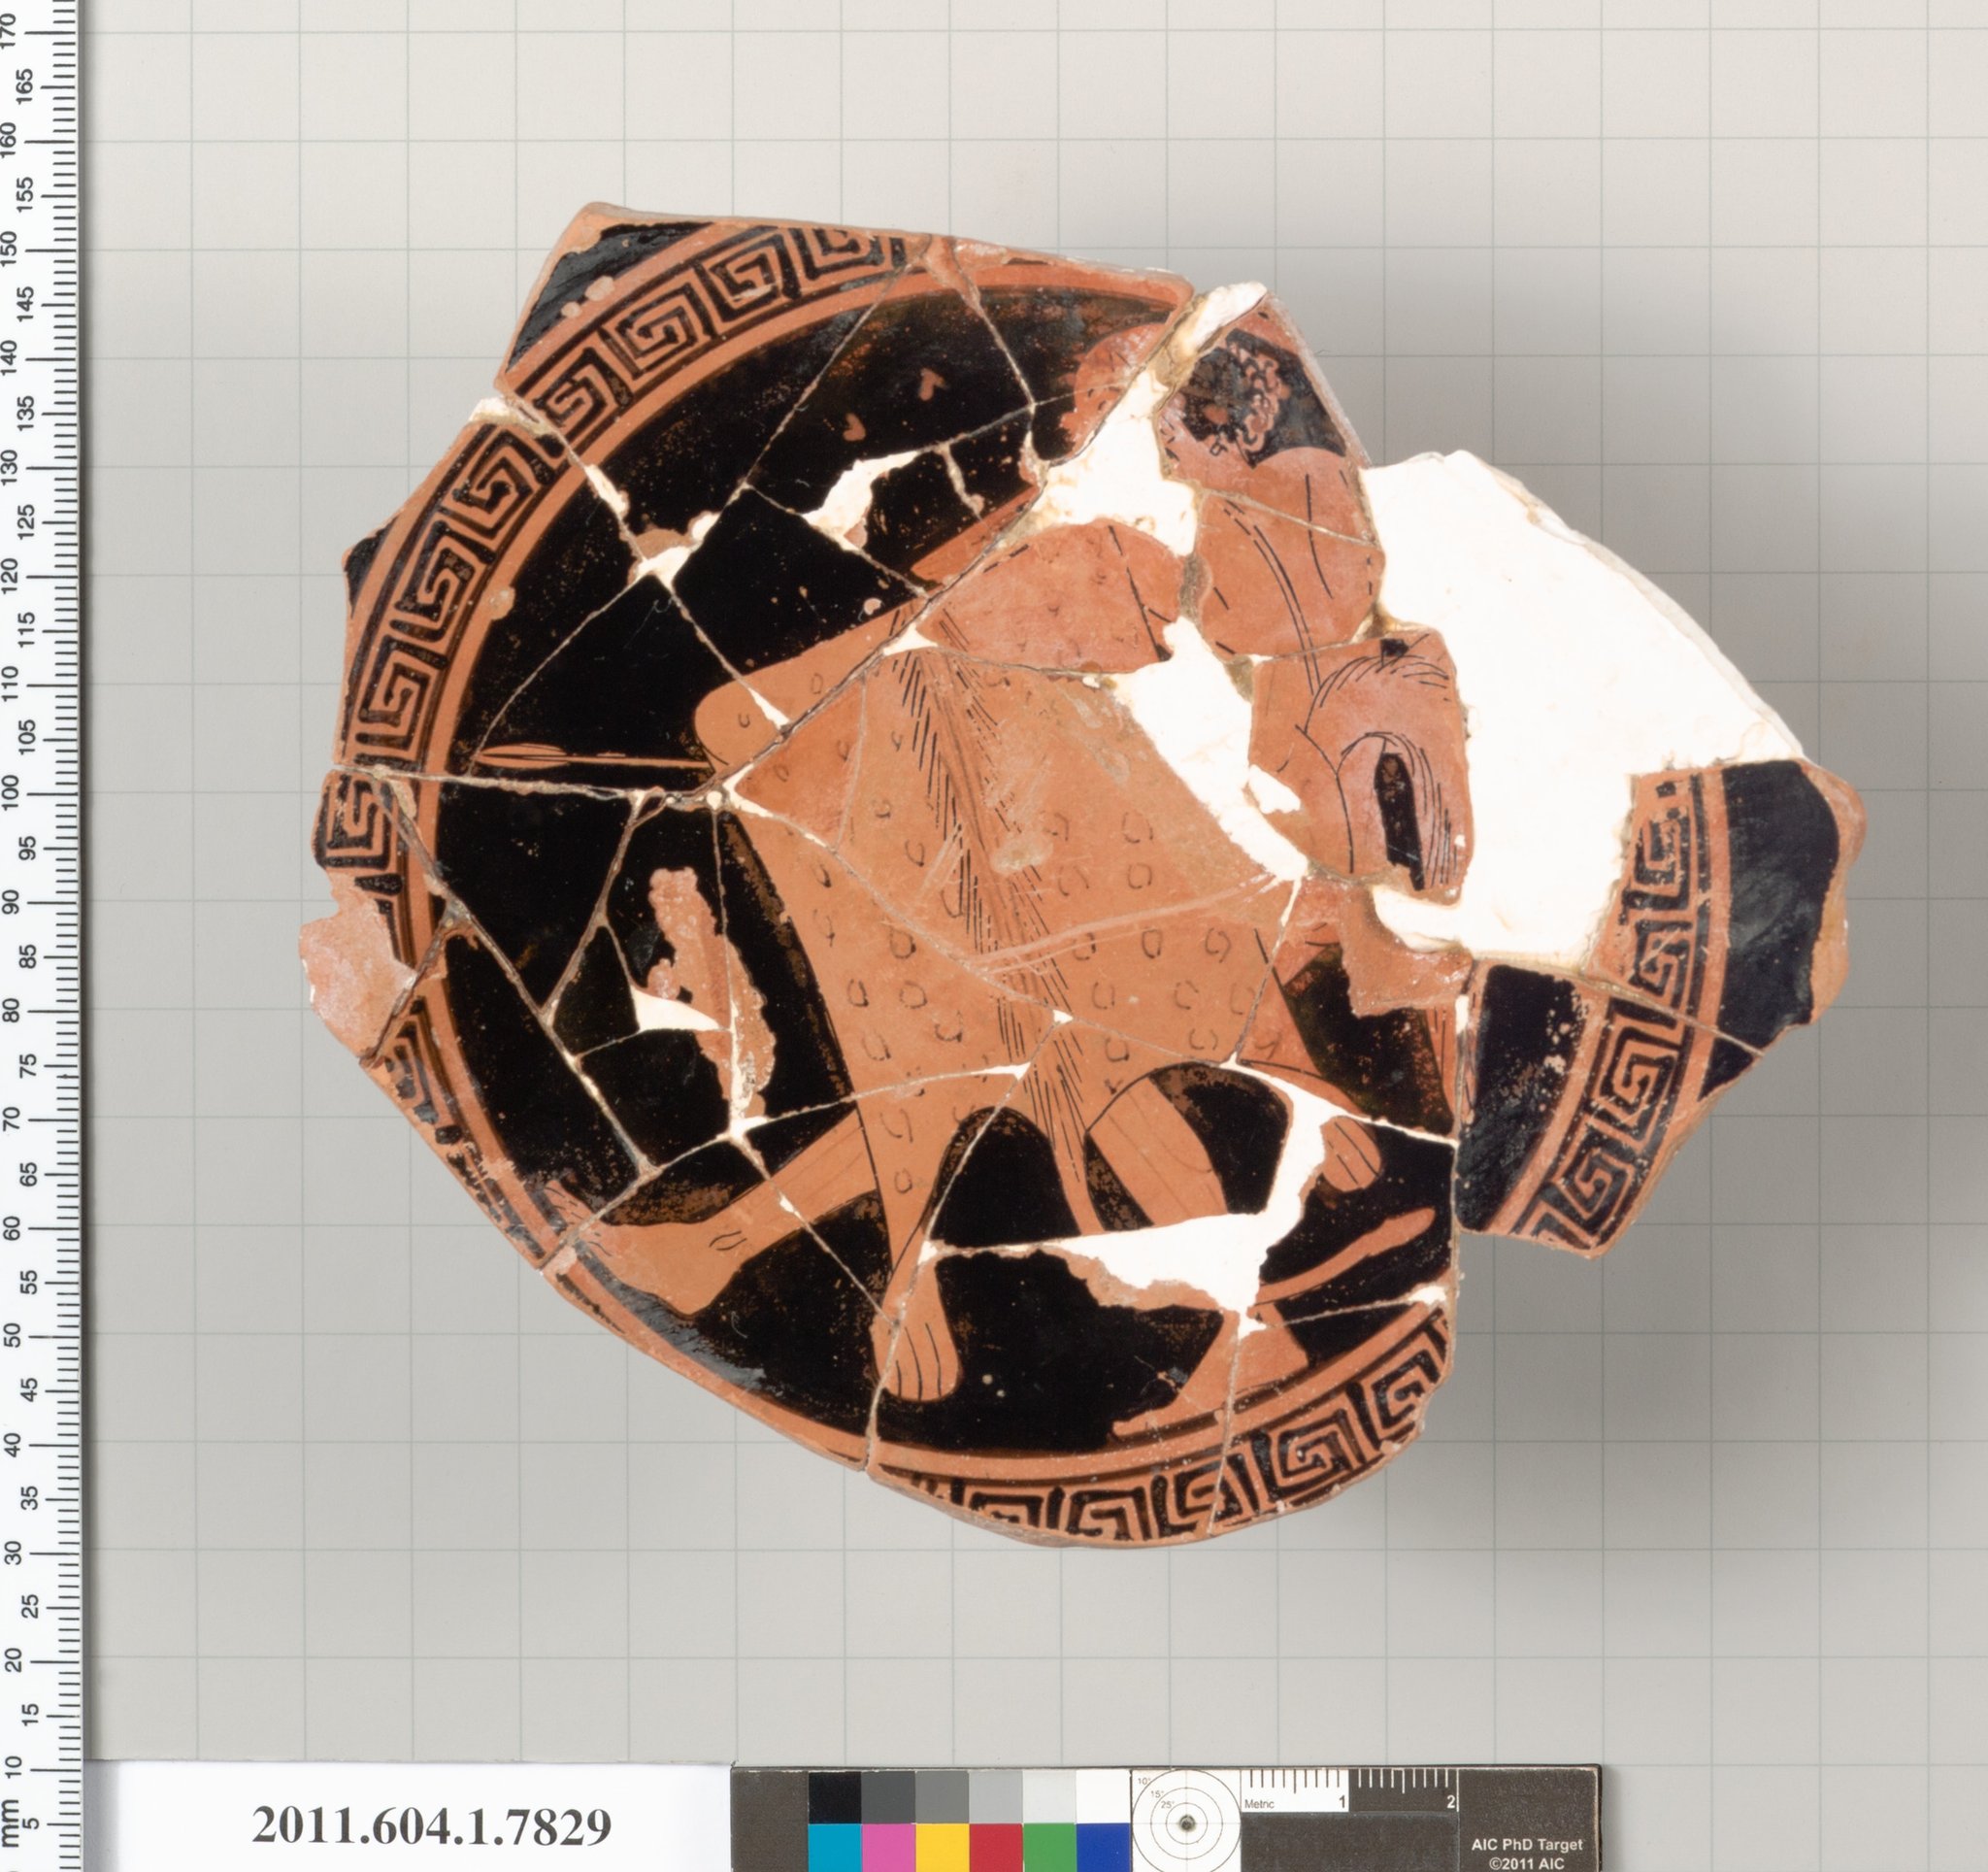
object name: kylix fragment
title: Terracotta fragment of a kylix (drinking cup)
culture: greek, attic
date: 470-460 BCE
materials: terracotta